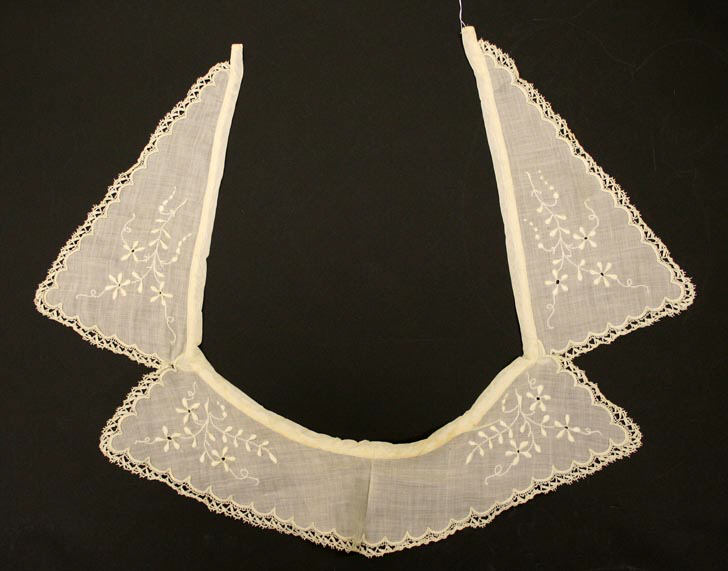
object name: collar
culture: american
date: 1700-1939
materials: cotton